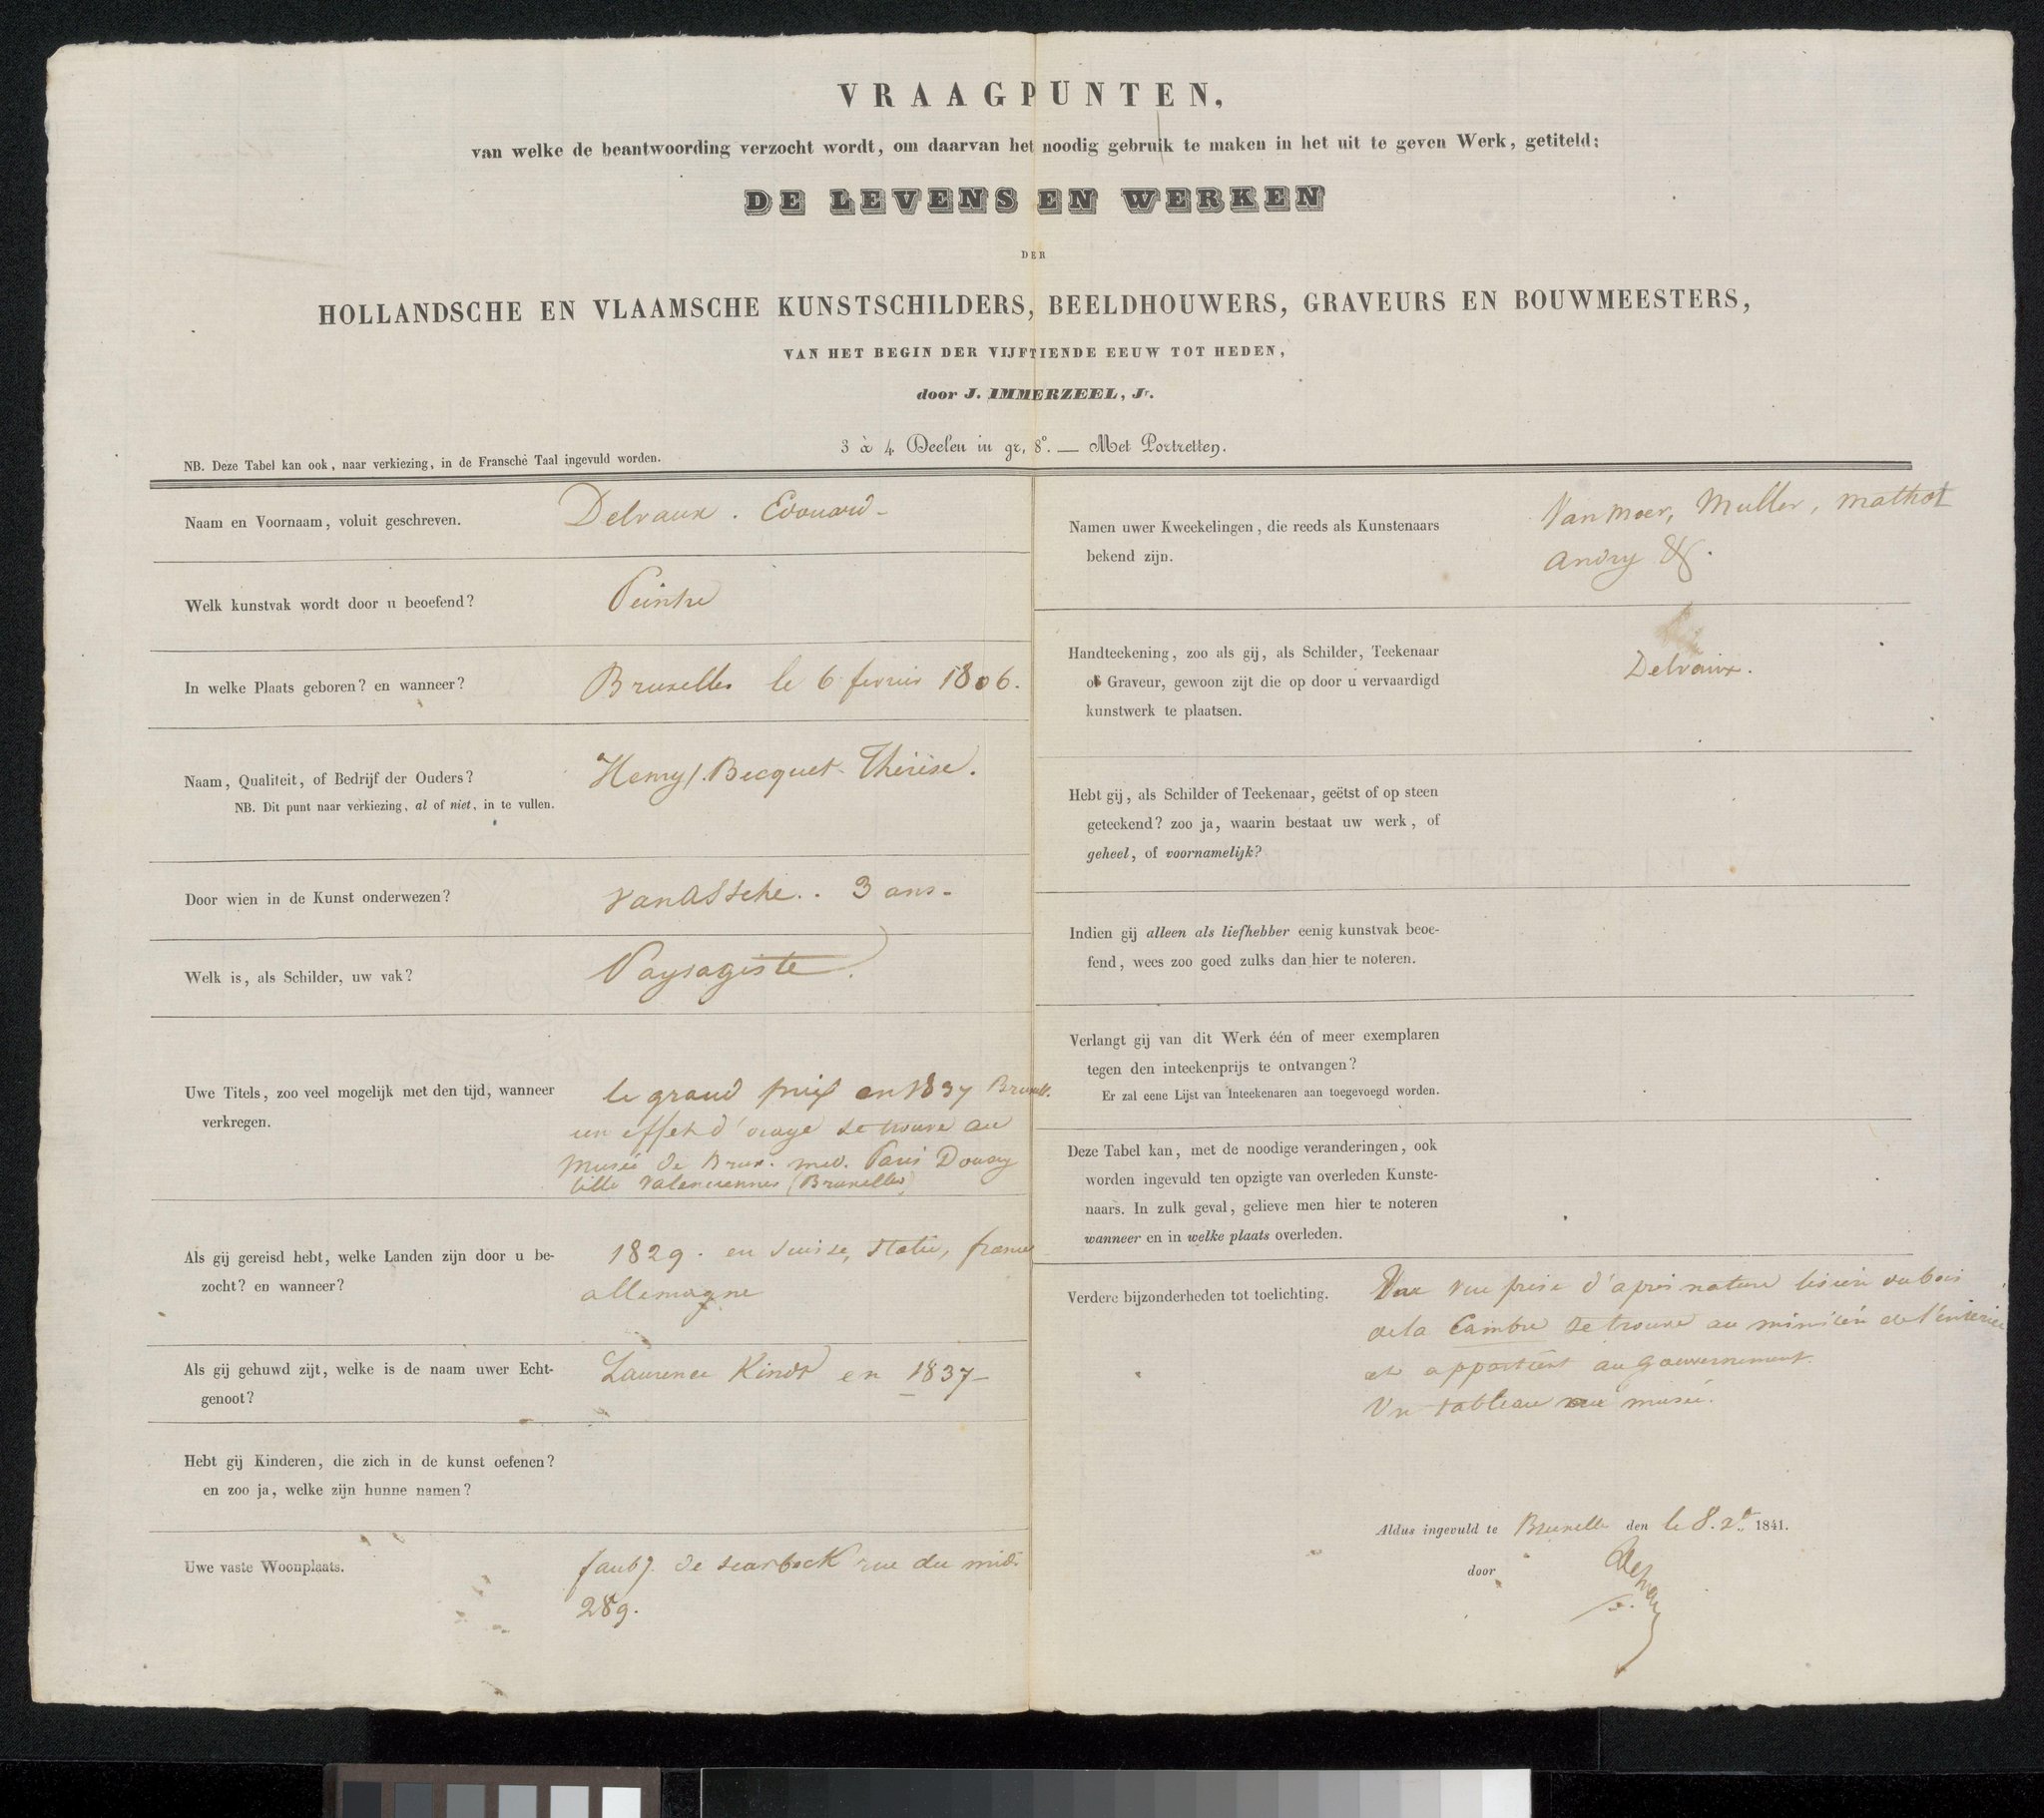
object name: questionnaire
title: Enquêteformulier ingevuld door Edouard Delvaux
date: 1841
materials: ink, paper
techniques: pen, printing, writing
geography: brussels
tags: painter, edouard delvaux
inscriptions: inscription: ‘Vraagpunten,/ van welke de beantwoording verzocht wordt, om daarvan het noodig gebruik te maken in het uit te geven Werk, getiteld: De levens en werken/ der Hollandsche en Vlaamsche kunstschilders, beeldhouwers,/ graveurs en bouwmeesters, van het begin der vijftiende eeuw tot heden/ door J. Immerzeel, Jr.’, watermark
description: Opgenomen in: Immerzeel, J. Jr., De levens en werken der Hollandsche en Vlaamsche kunstschilders, beeldhouwers, graveurs en bouwmeesters, van het begin der vijftiende eeuw tot heden, Amsterdam: J.C. van Kesteren, 1842-1843.